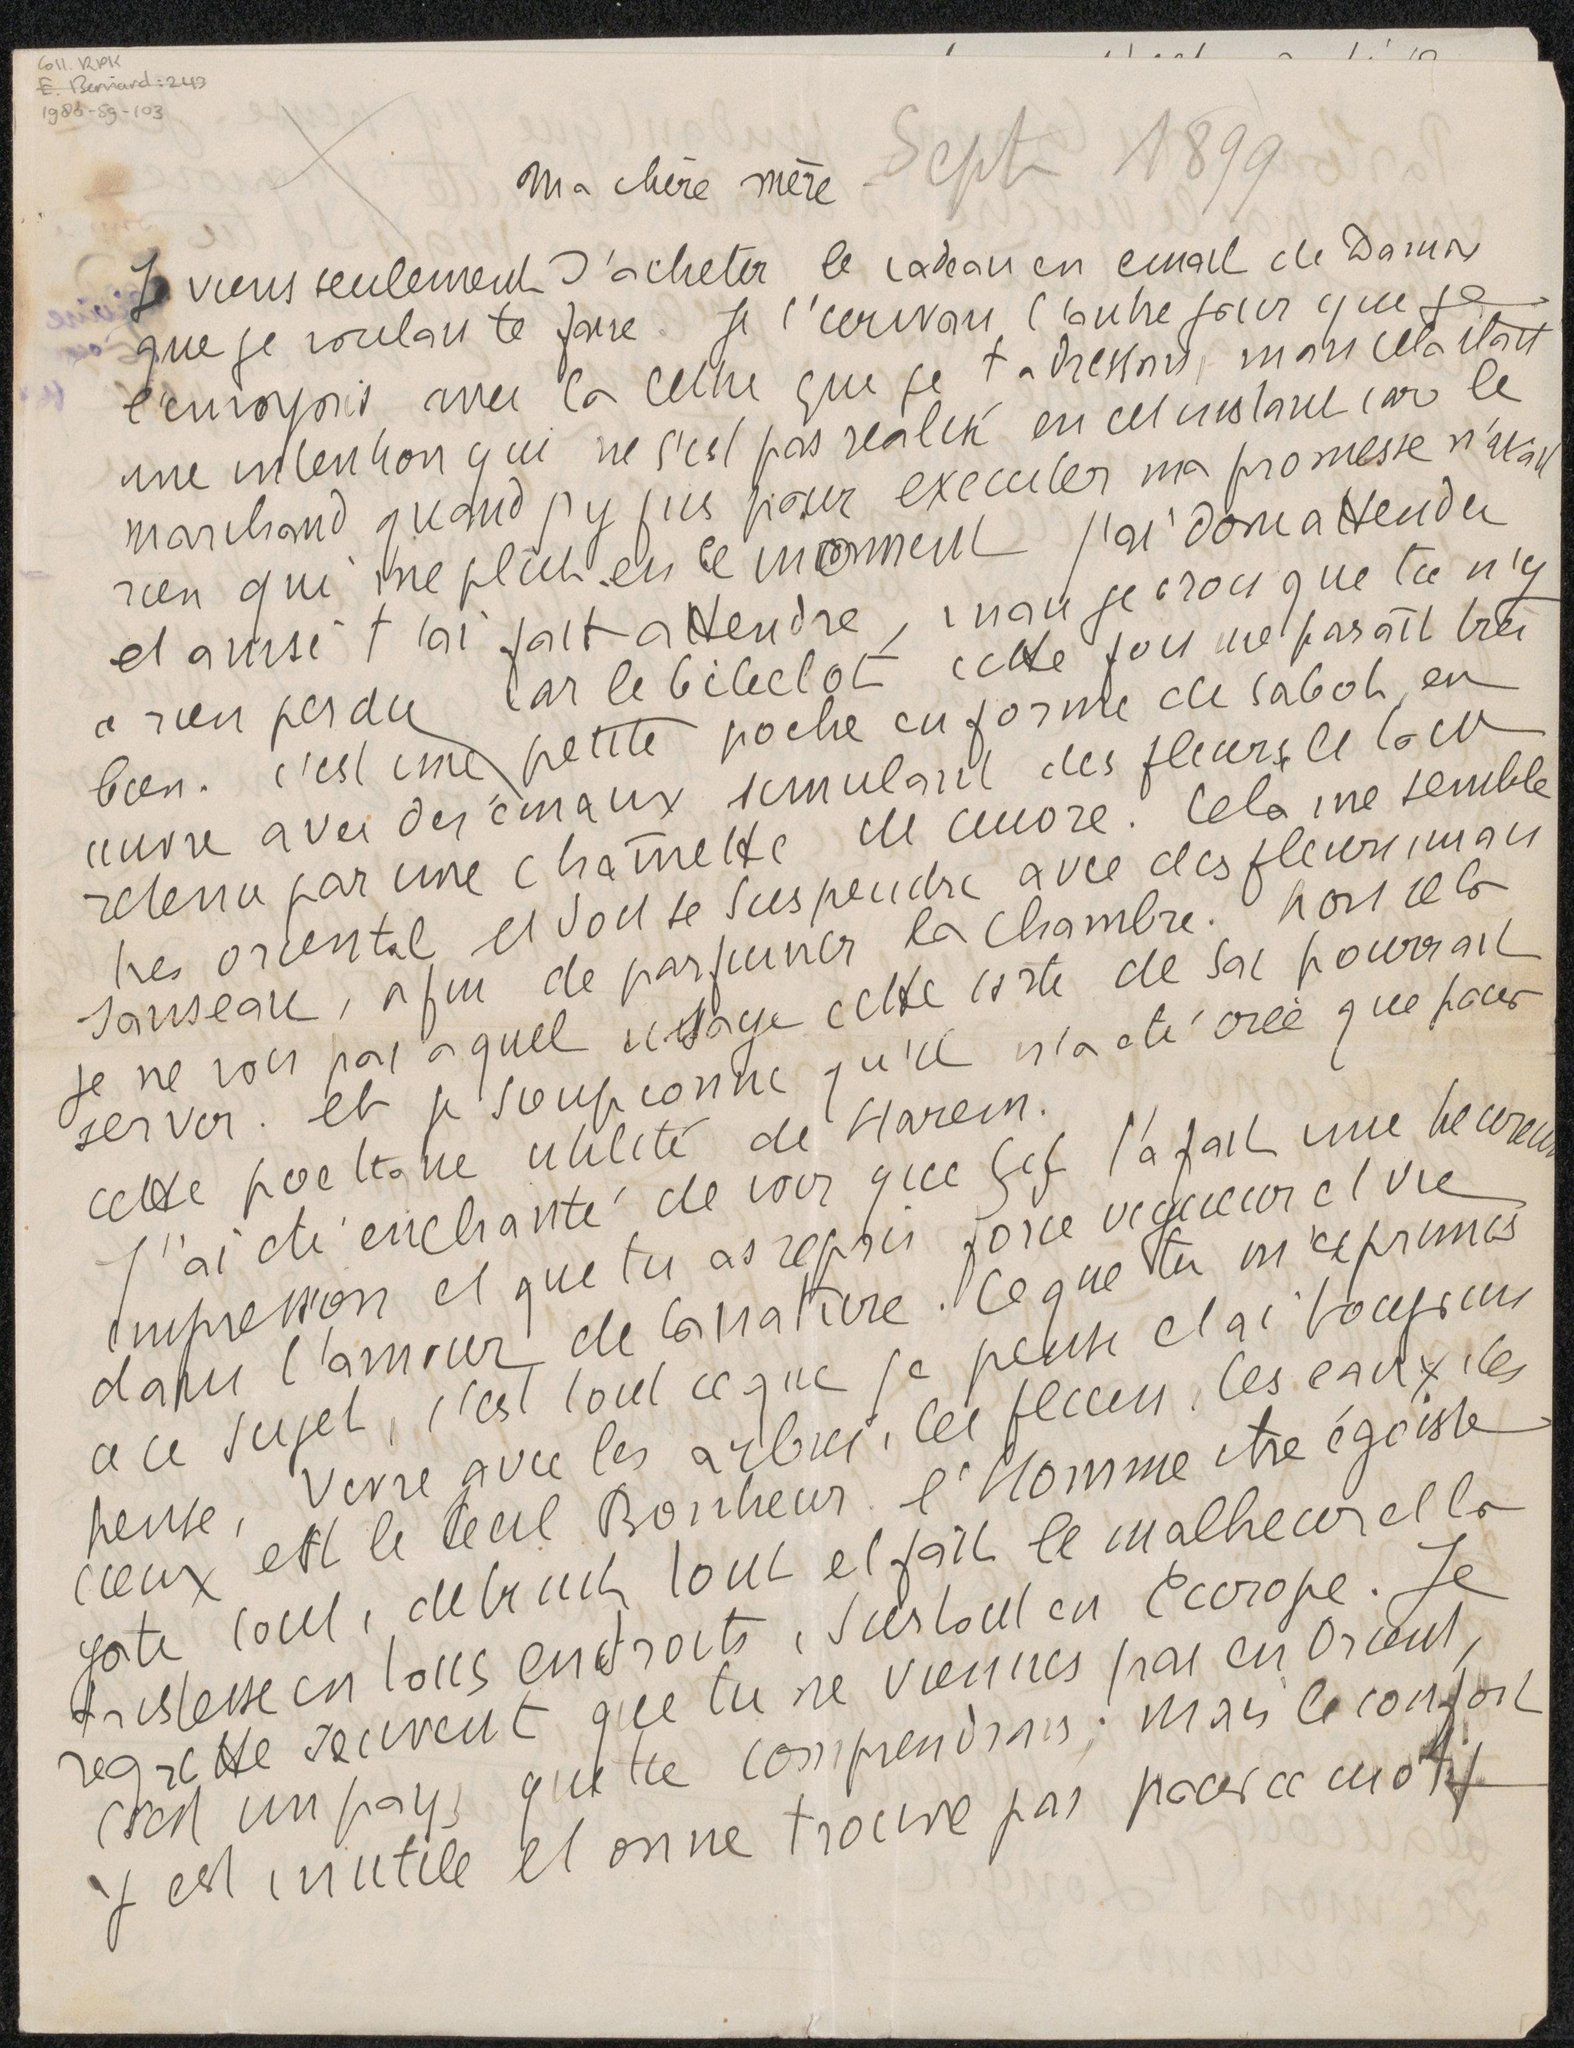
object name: letter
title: Brief aan Héloïse Bernard-Bodin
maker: émile bernard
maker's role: print maker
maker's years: 1868-1941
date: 1899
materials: ink, paper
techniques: pen, writing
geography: cairo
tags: héloïse bernard-bodin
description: Brief gedateerd Sept 1899 in latere hand.